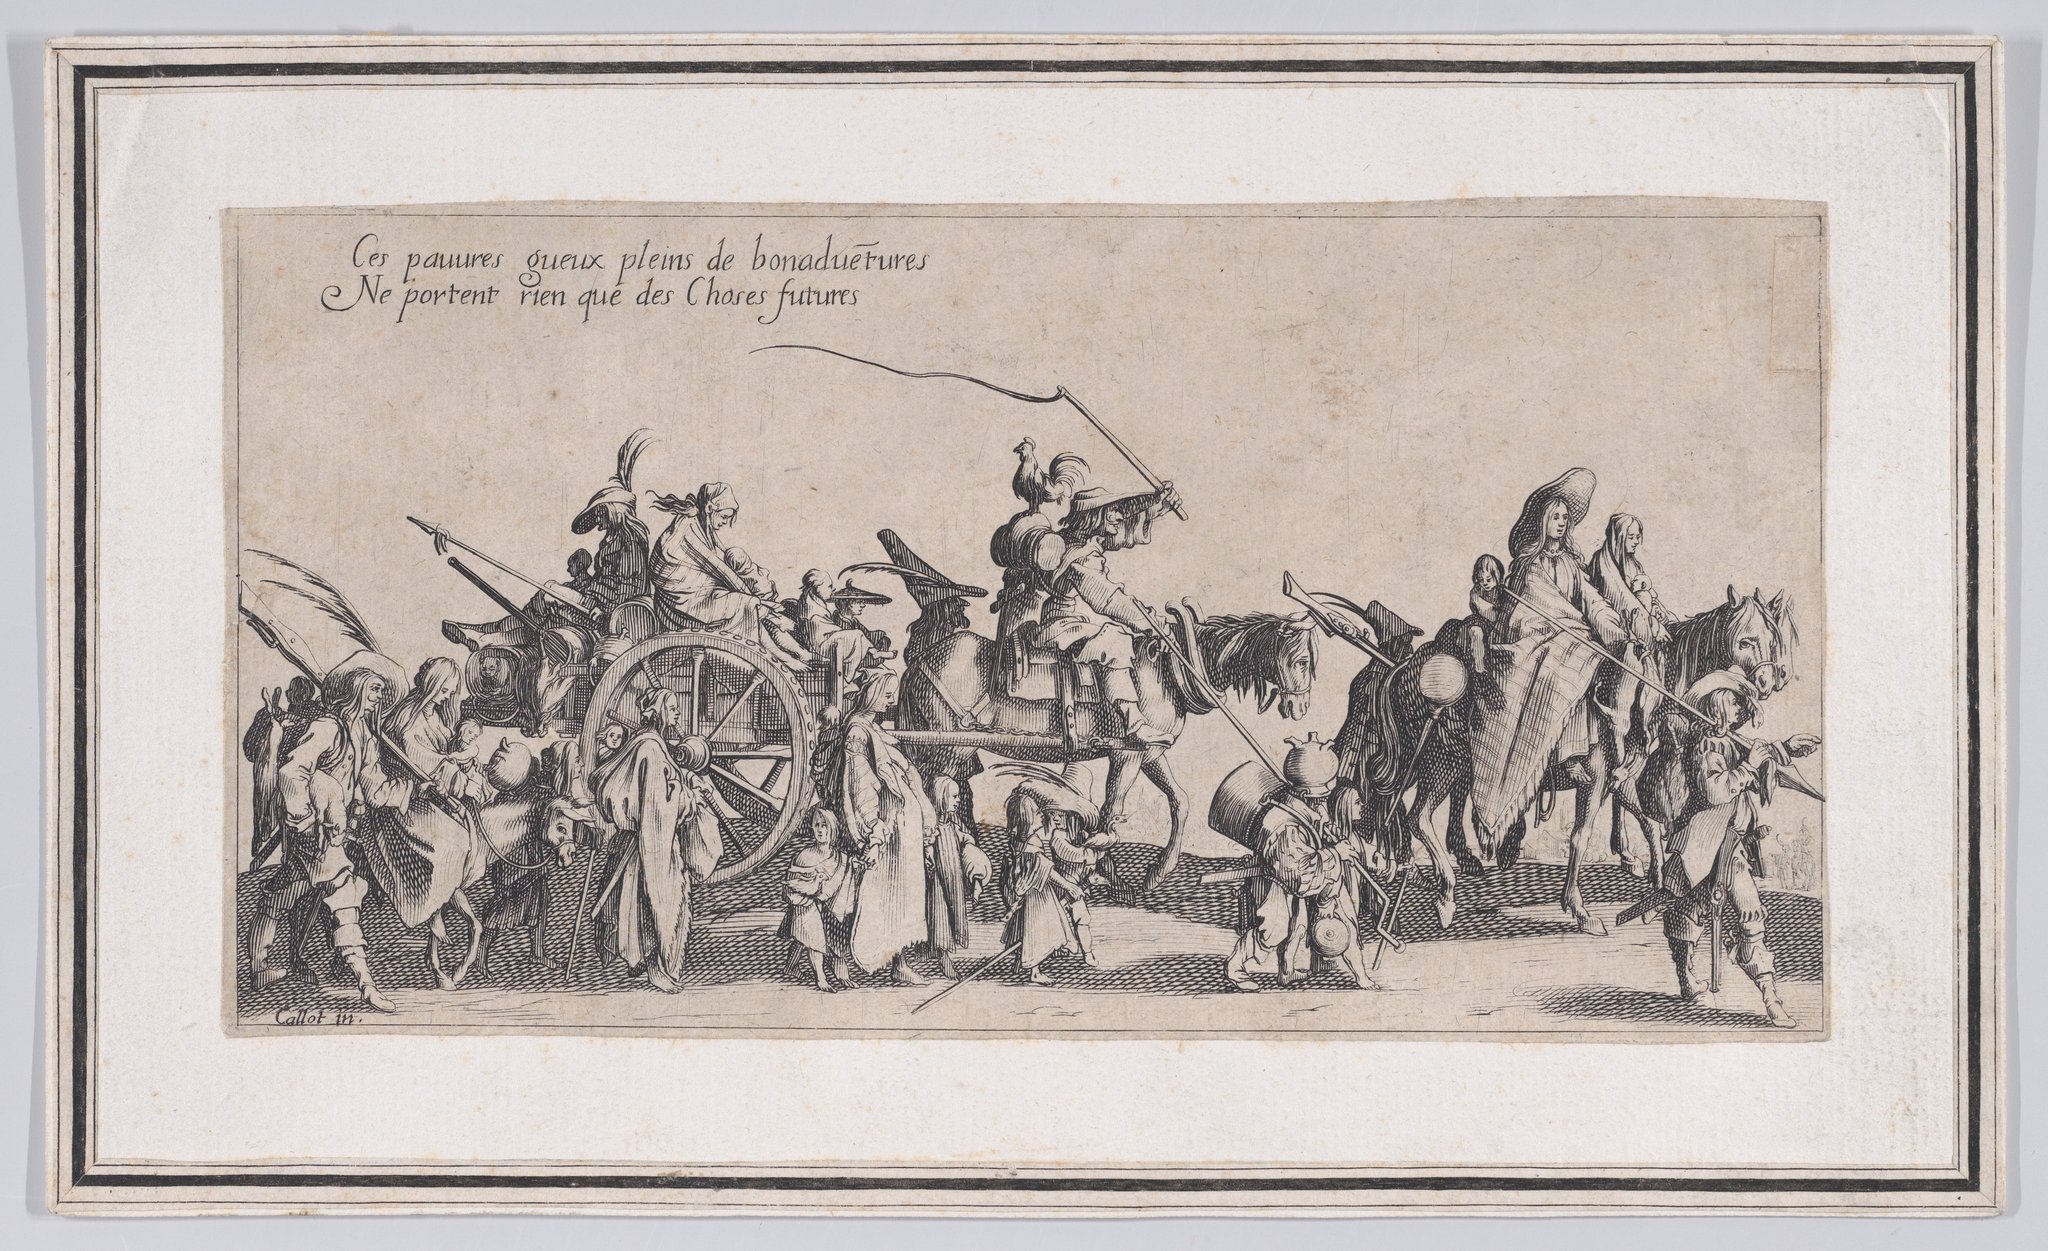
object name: print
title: Copy of Les Bohémiens en Marche: L'Arrière-Garde, pièce aussi appelée Le Départ (The Gypsies Travelling: The Rear Guard, also called The Departure), from "Le Bohémiens..."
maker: Anonymous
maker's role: artist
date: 1601-1700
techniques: engraving, etching